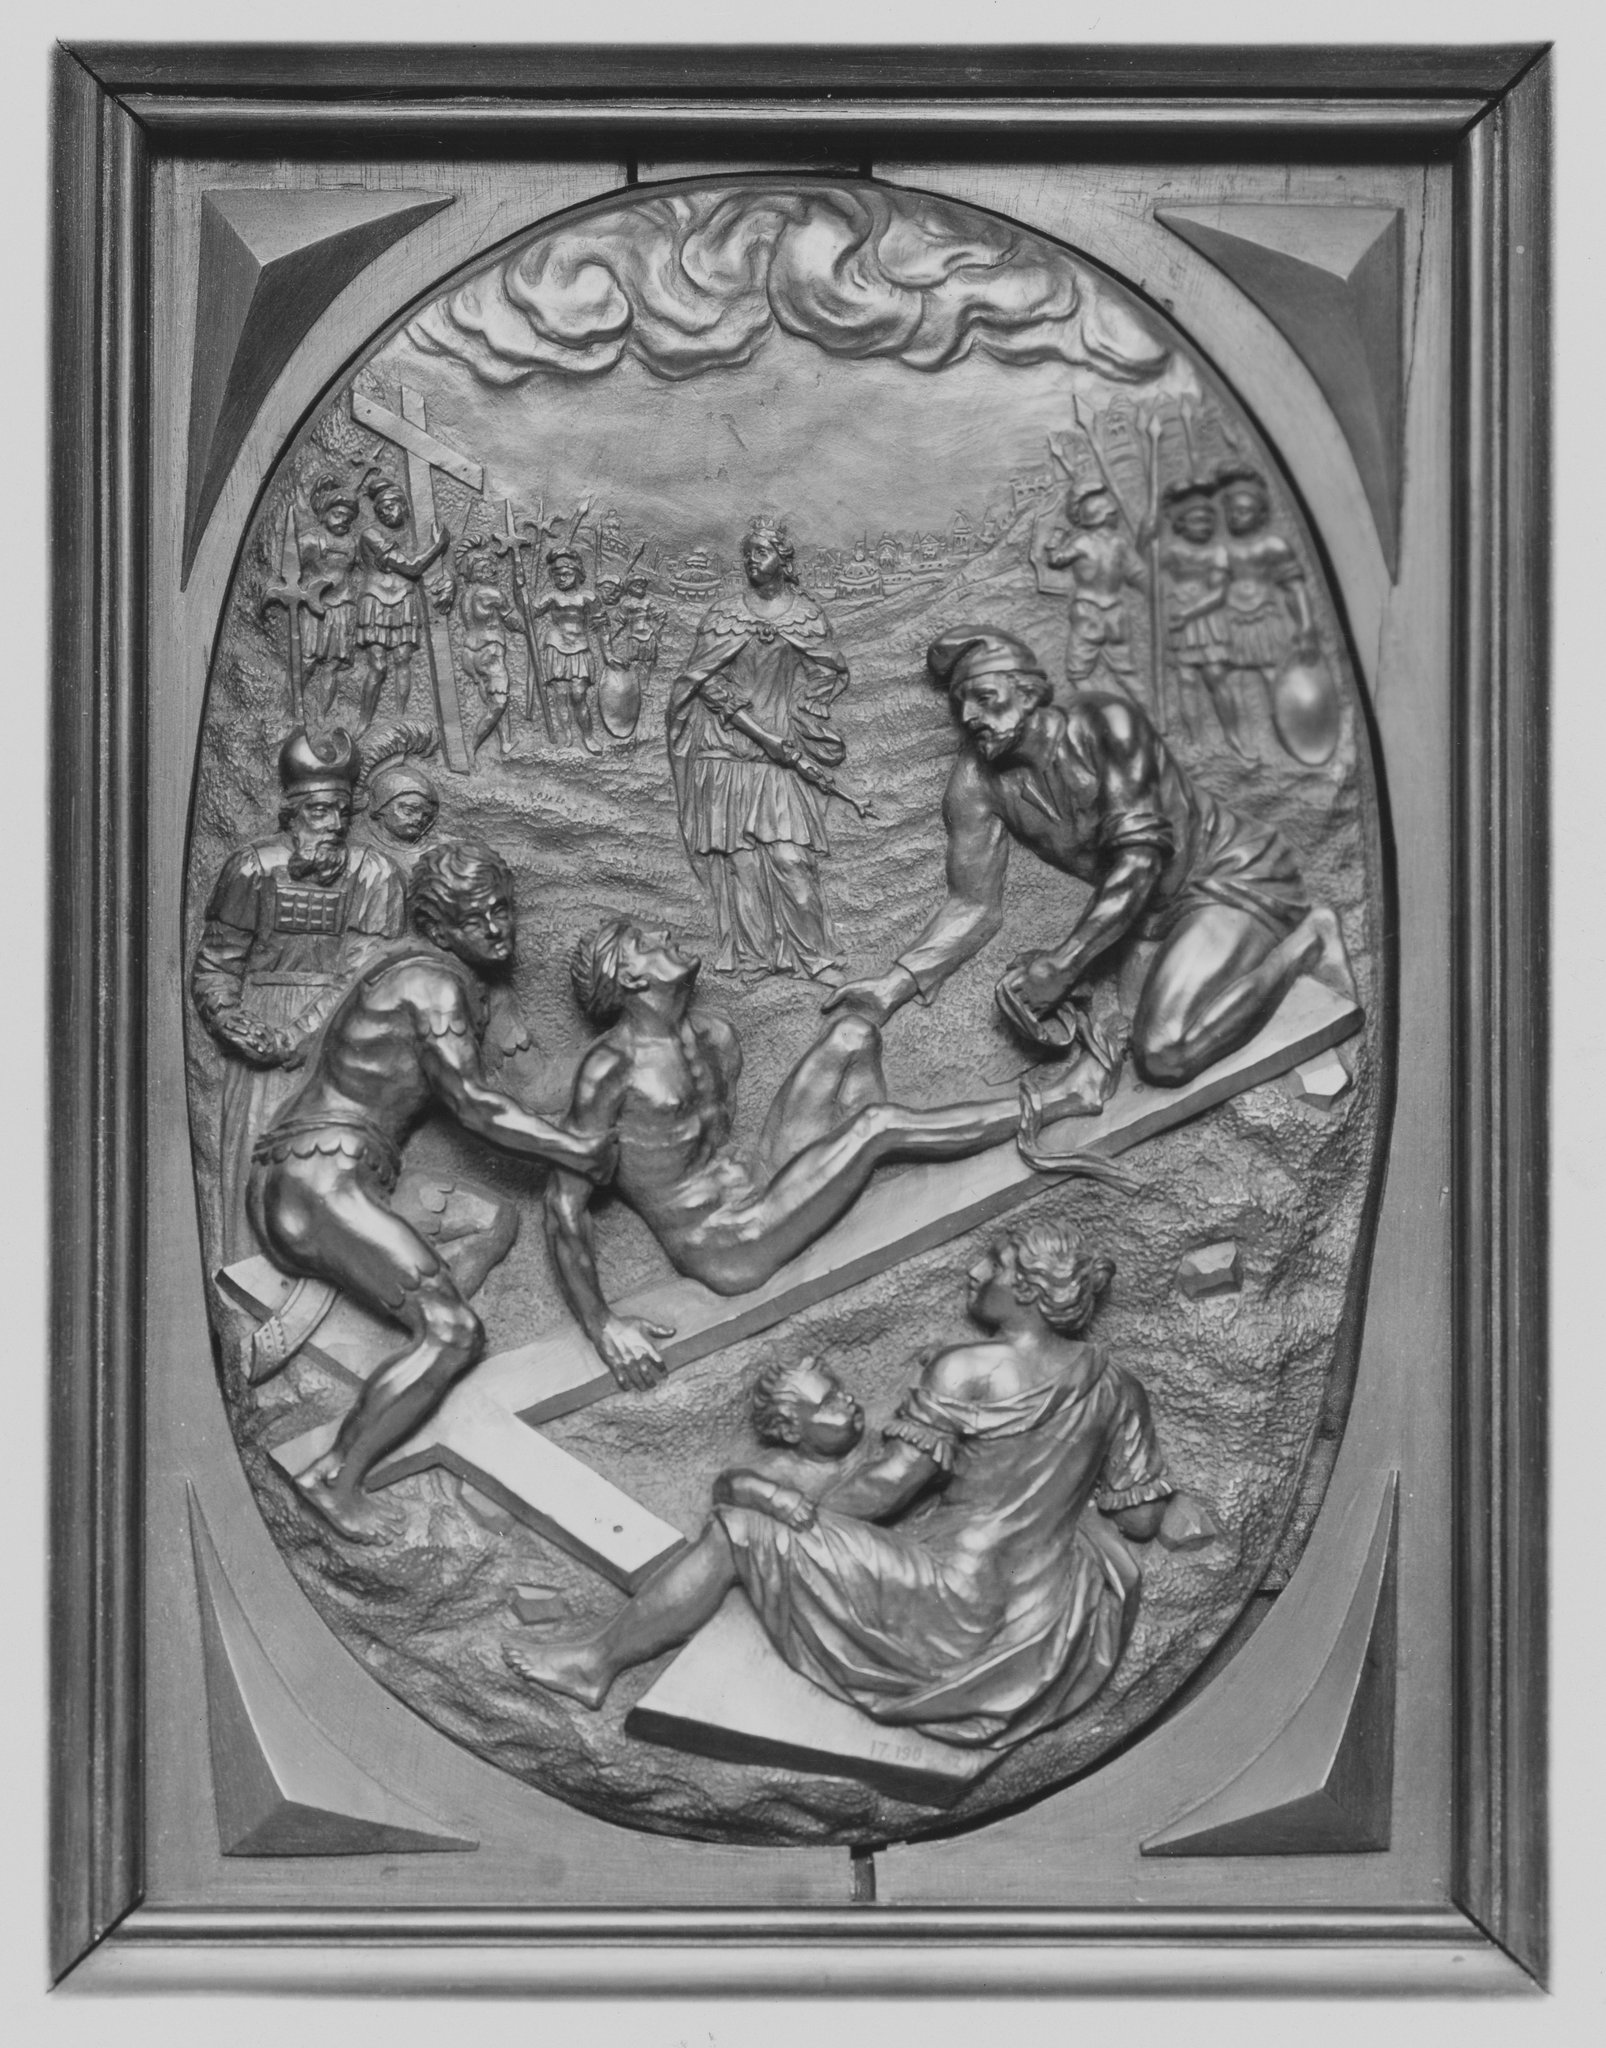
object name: high relief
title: The Invention of the Cross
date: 1601-1700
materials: wood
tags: men,cross,crucifixion